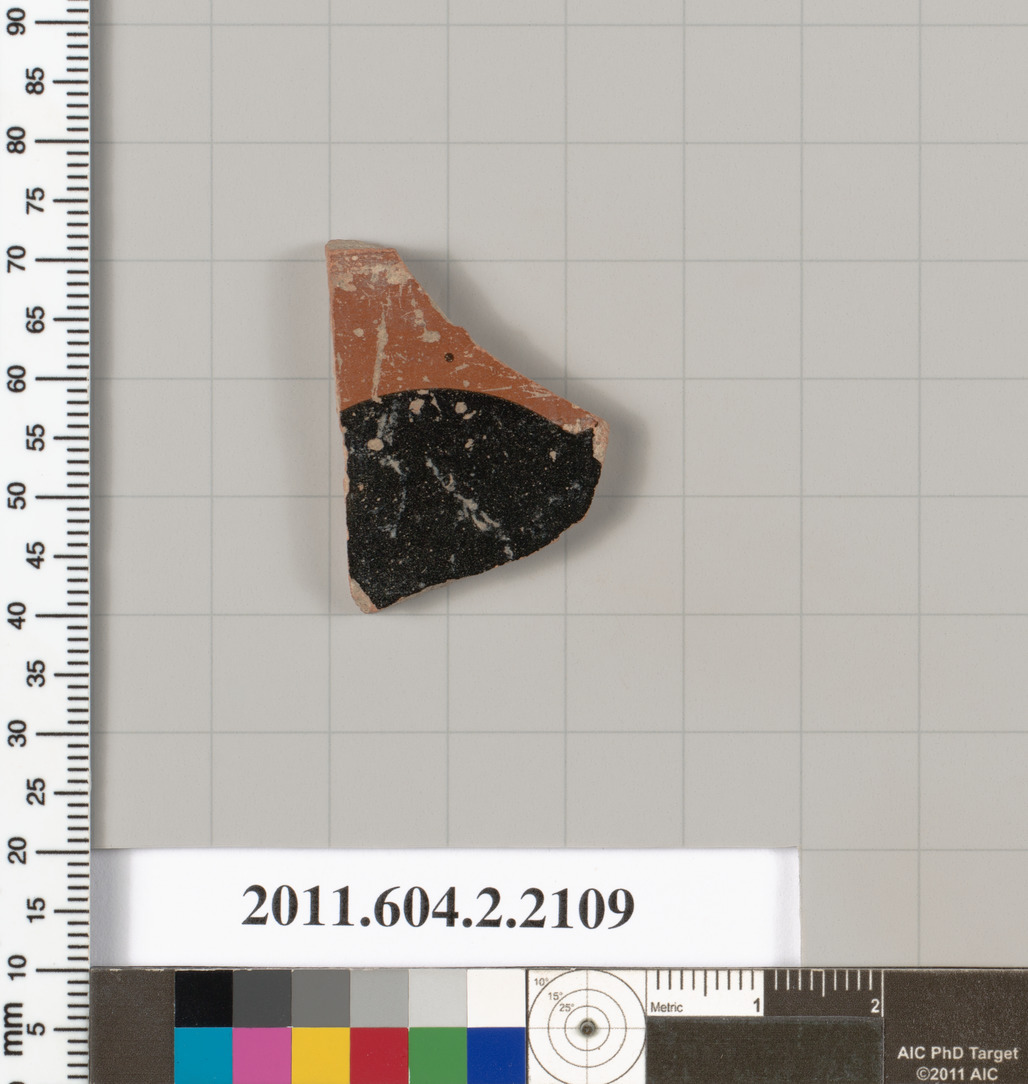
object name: pot fragment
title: Terracotta fragment of a pot; glazed on the inside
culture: greek, attic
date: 500-401 BCE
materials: terracotta